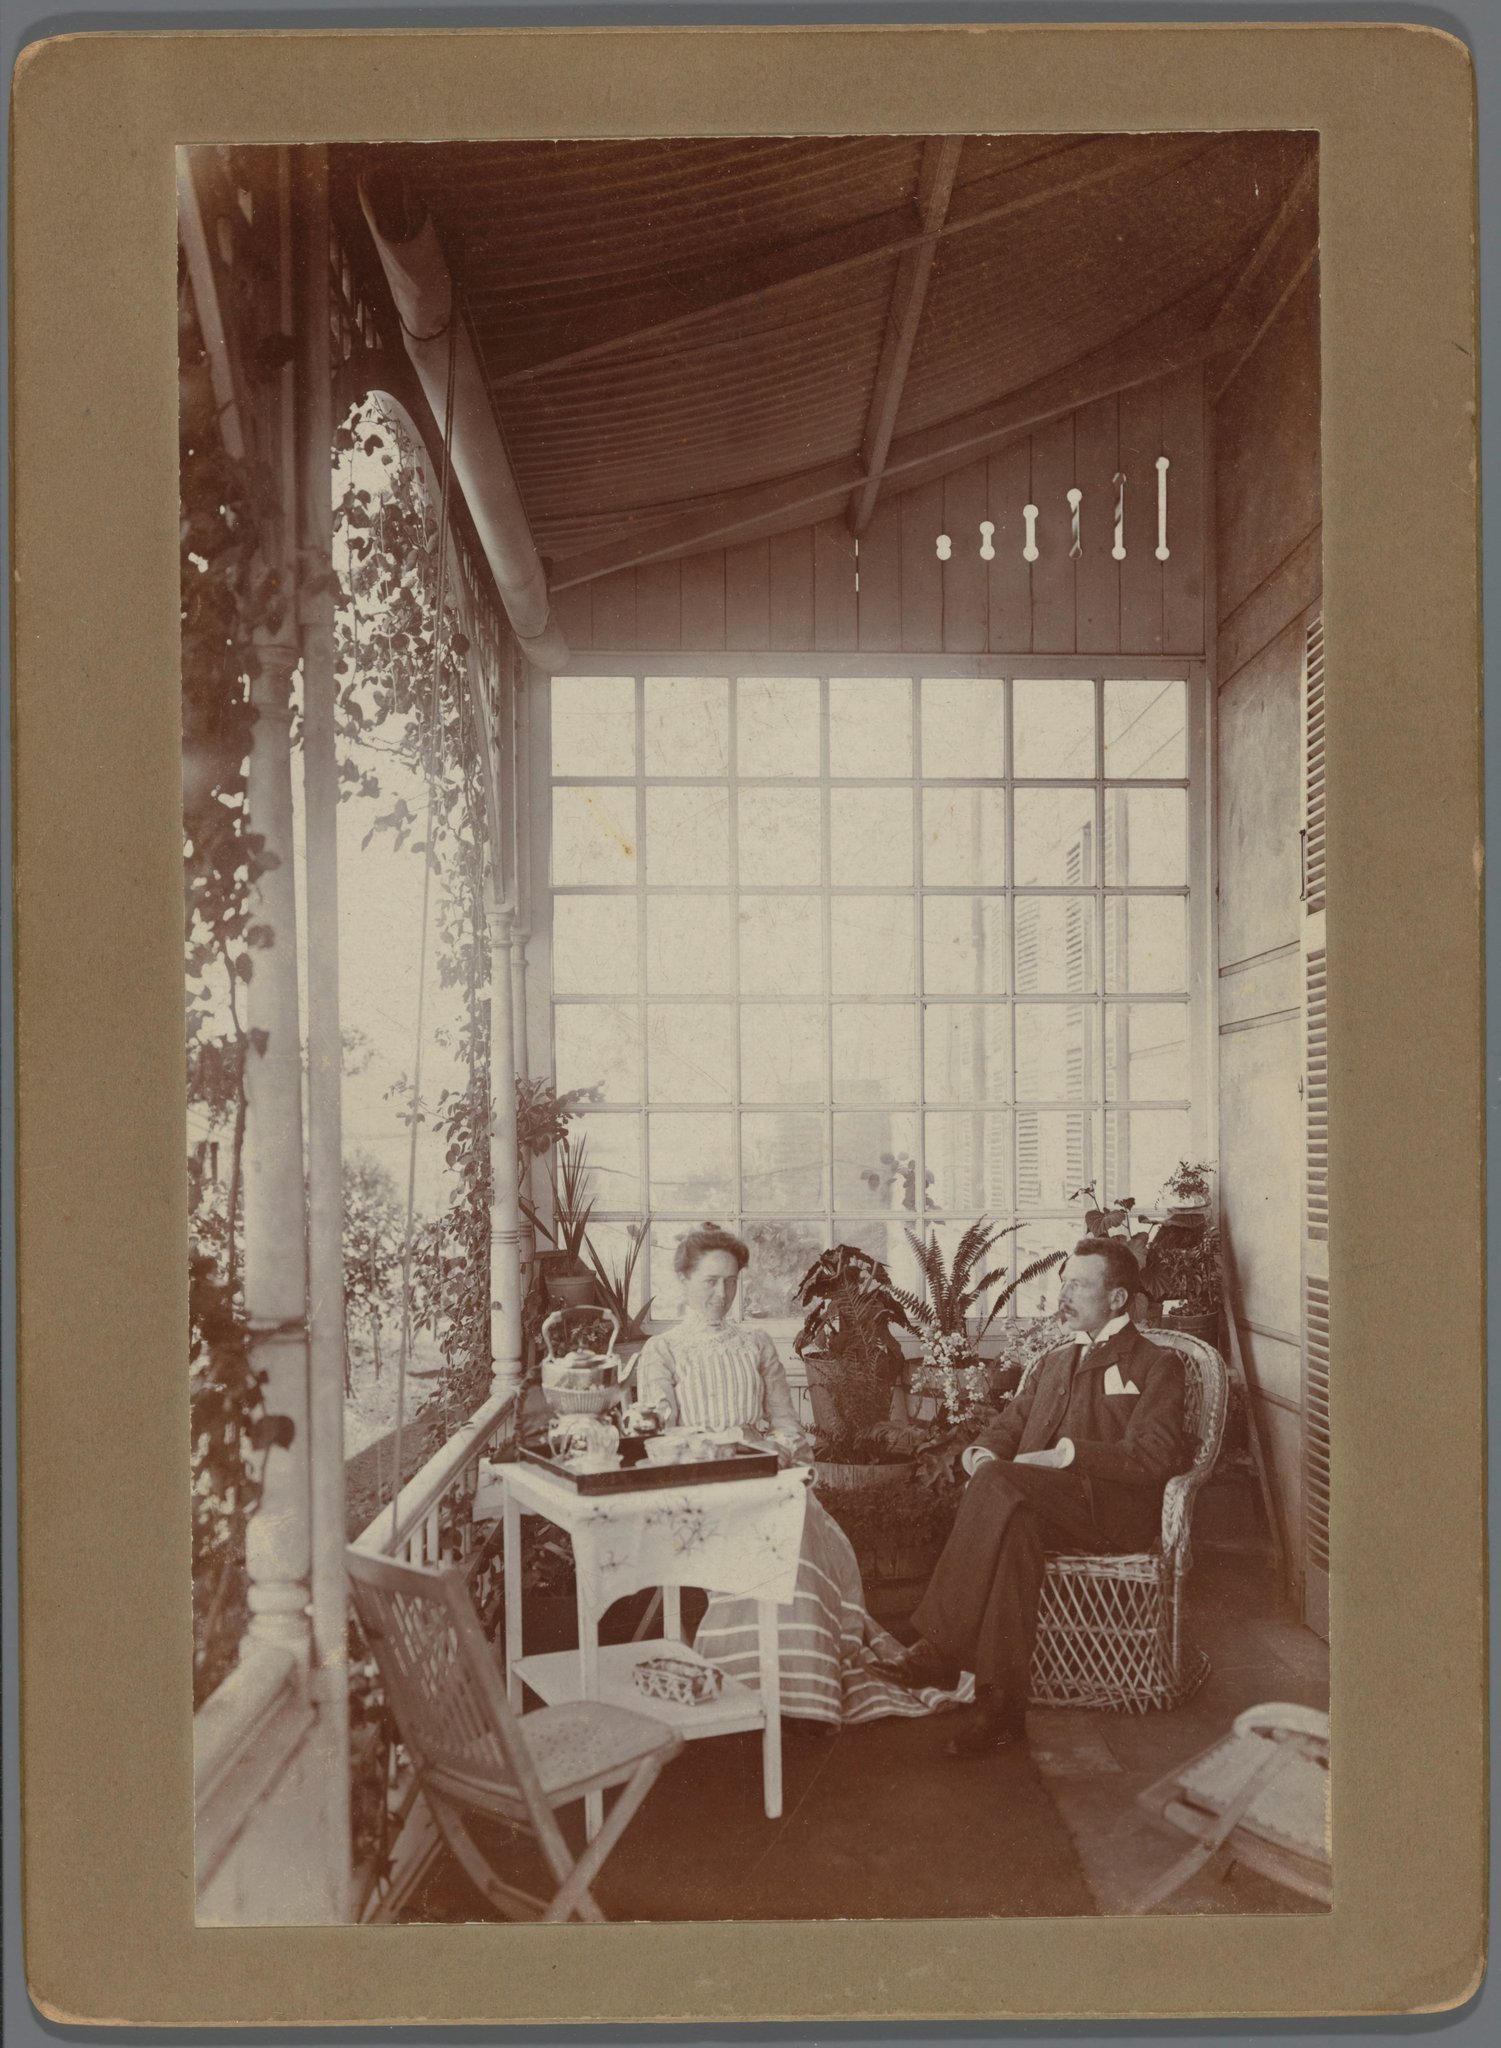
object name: photograph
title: Portret van Willem Jacobus Fockens en Anna Gesiena Jonker op de veranda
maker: cornelia hendrika jonker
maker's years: 1874-1924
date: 1880-1920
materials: cardboard, photographic support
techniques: collodion silver print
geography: south africa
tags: historical persons, loggia, verandah, porch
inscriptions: annotation: ‘t. Anne en o. Willem Fockens’